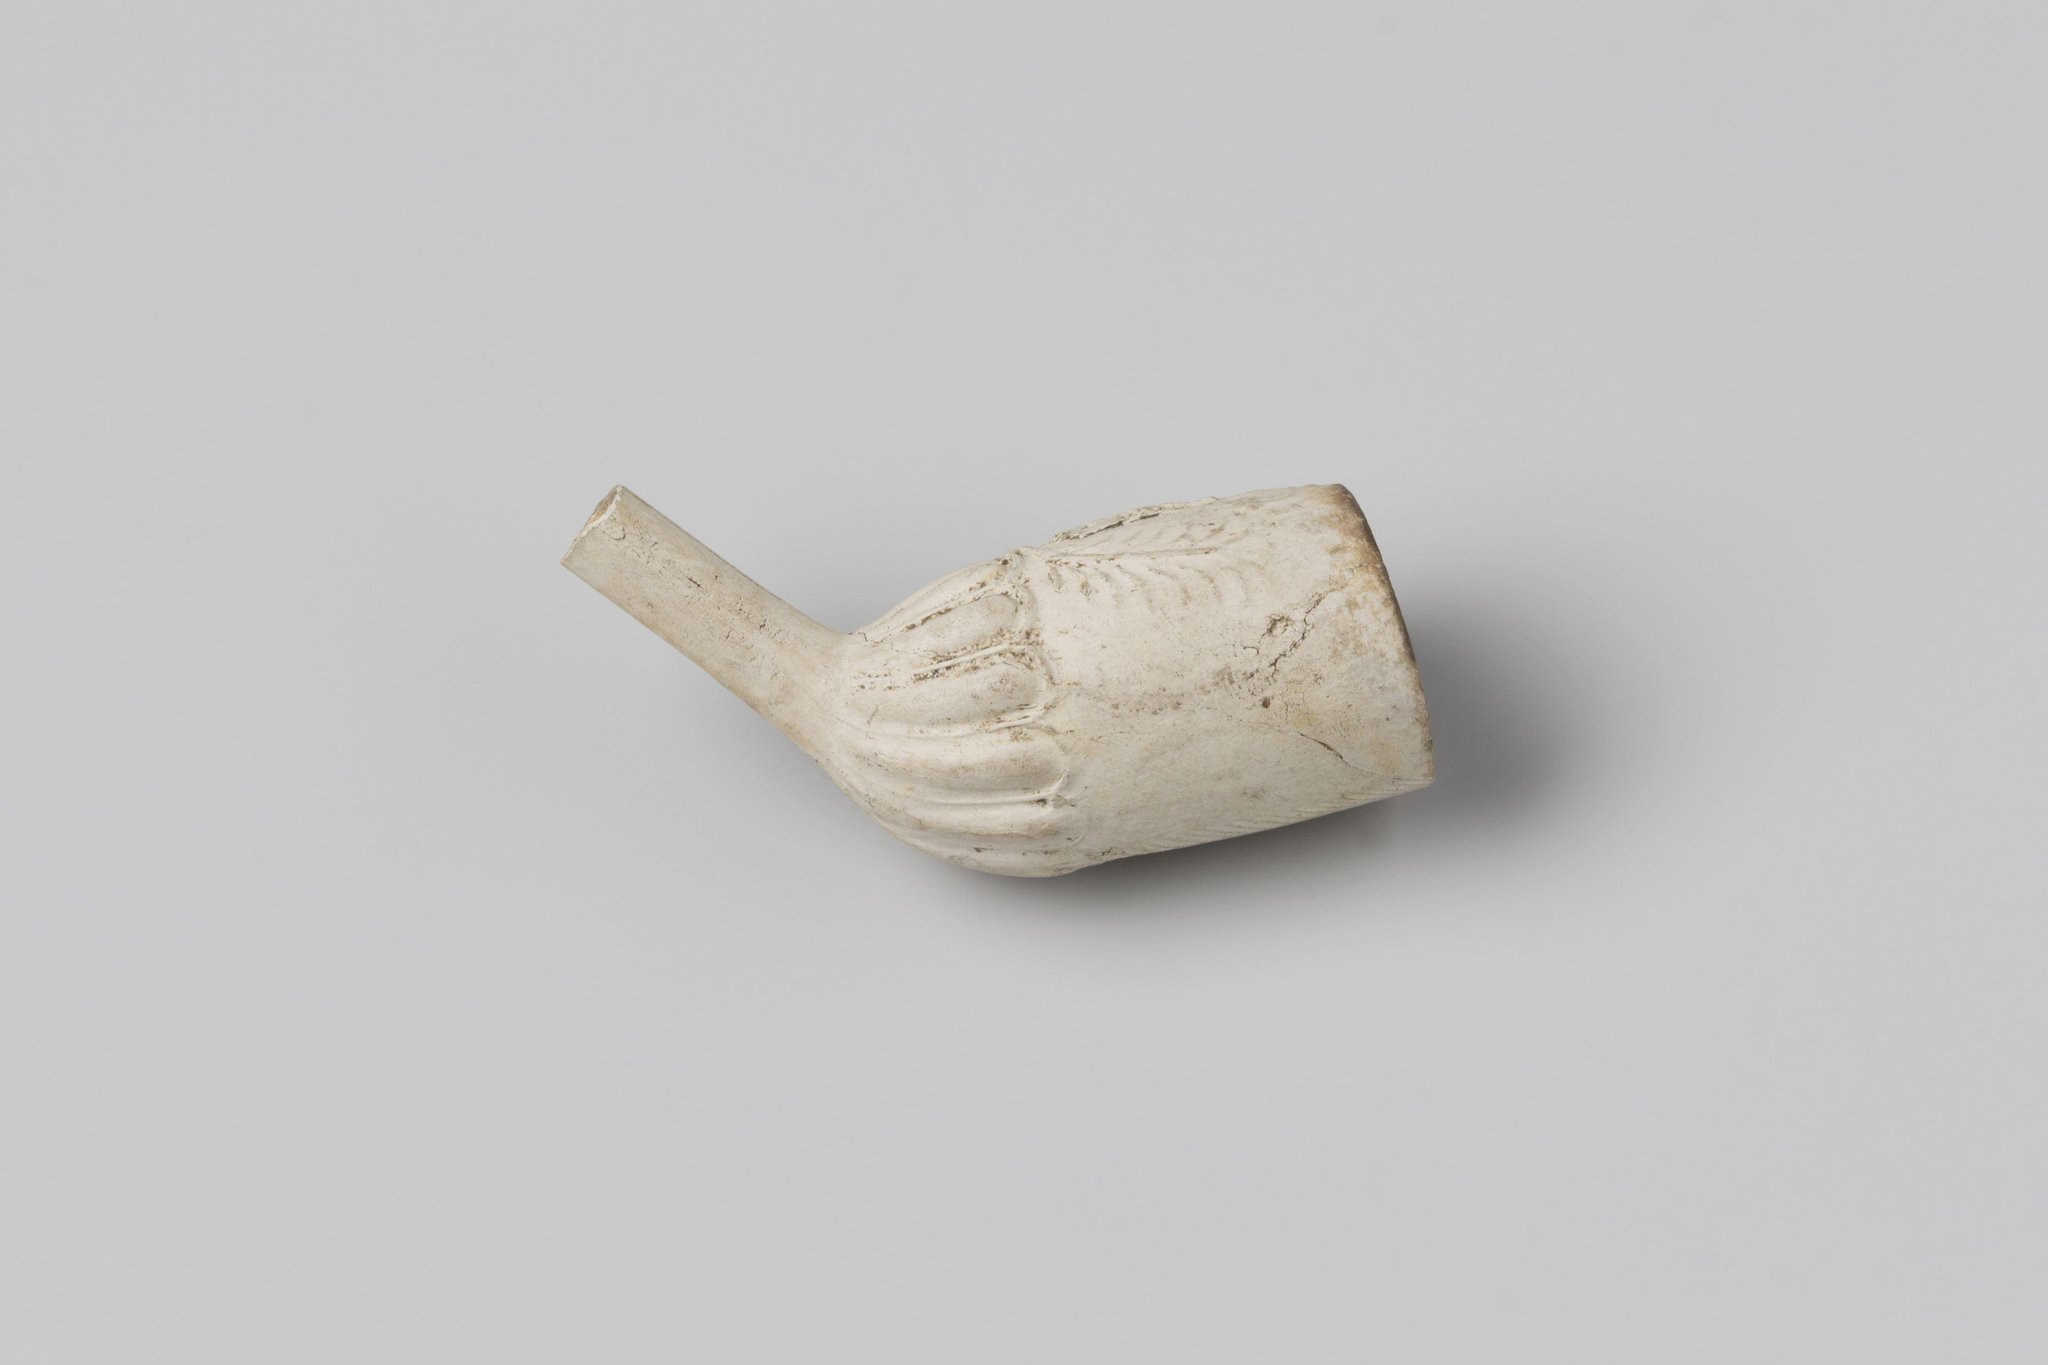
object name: fragment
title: Fragment tabakspijp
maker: Anonymous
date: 1750-1785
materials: clay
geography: schoonhoven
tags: the hague, rotterdam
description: Fragment tabakspijp met twaalf knorren met omlijningen (floraal uitwaaiend motief) en een wapenschild met leeuw, omsloten door bloemtakken. Van de opgravingen op de Hofstede Arentsburg 1827-1831 onder toezicht van Professor Reuvens.